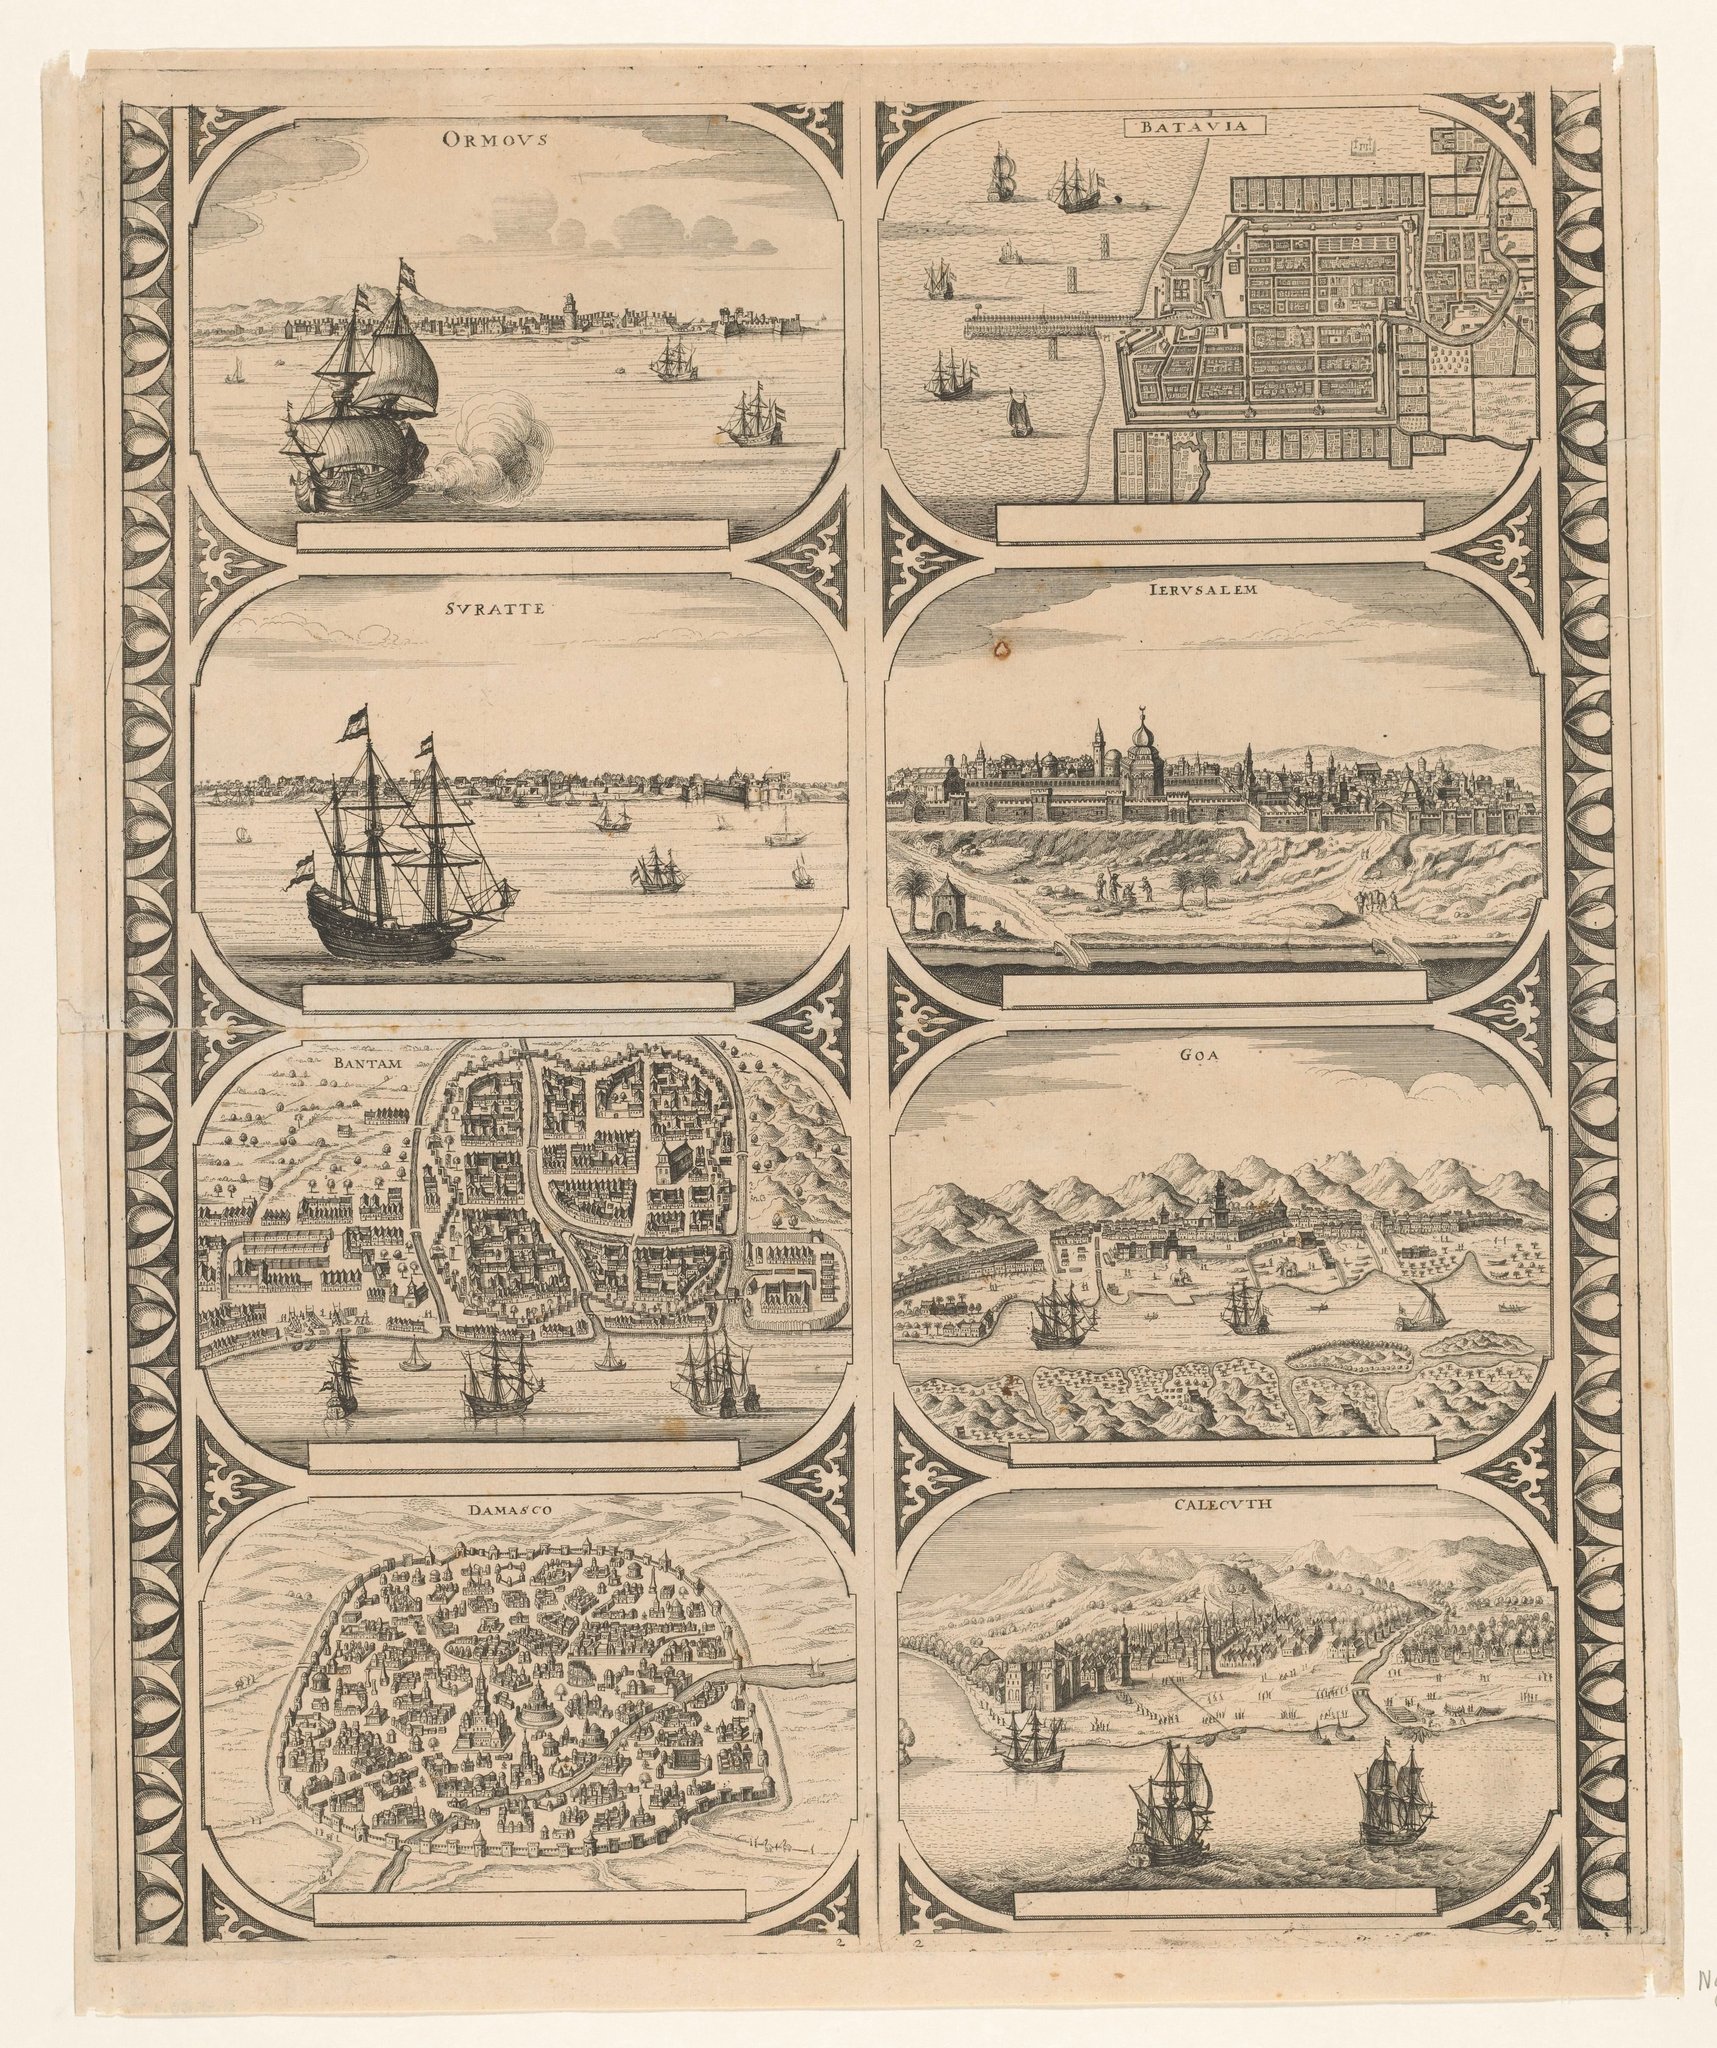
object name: print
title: Ormovs / Svrattte / Bantam / Damasco / Batavia / Iervsalem / Goa / Calecvth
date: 1670-1672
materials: paper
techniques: etching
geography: amsterdam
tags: maps of cities, prospect of city, town panorama, silhouette of city, batavia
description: Blad met twee verticale stroken elk met vier gezichten op de steden in Azië: Hormoz, Suratte, Bantam, Damascus, Batavia, Jeruzalem, Goa en Calcutta. Onversneden blad met acht randfiguren bedoeld om in stroken als omlijsting om een kaart van een werelddeel te plakken.